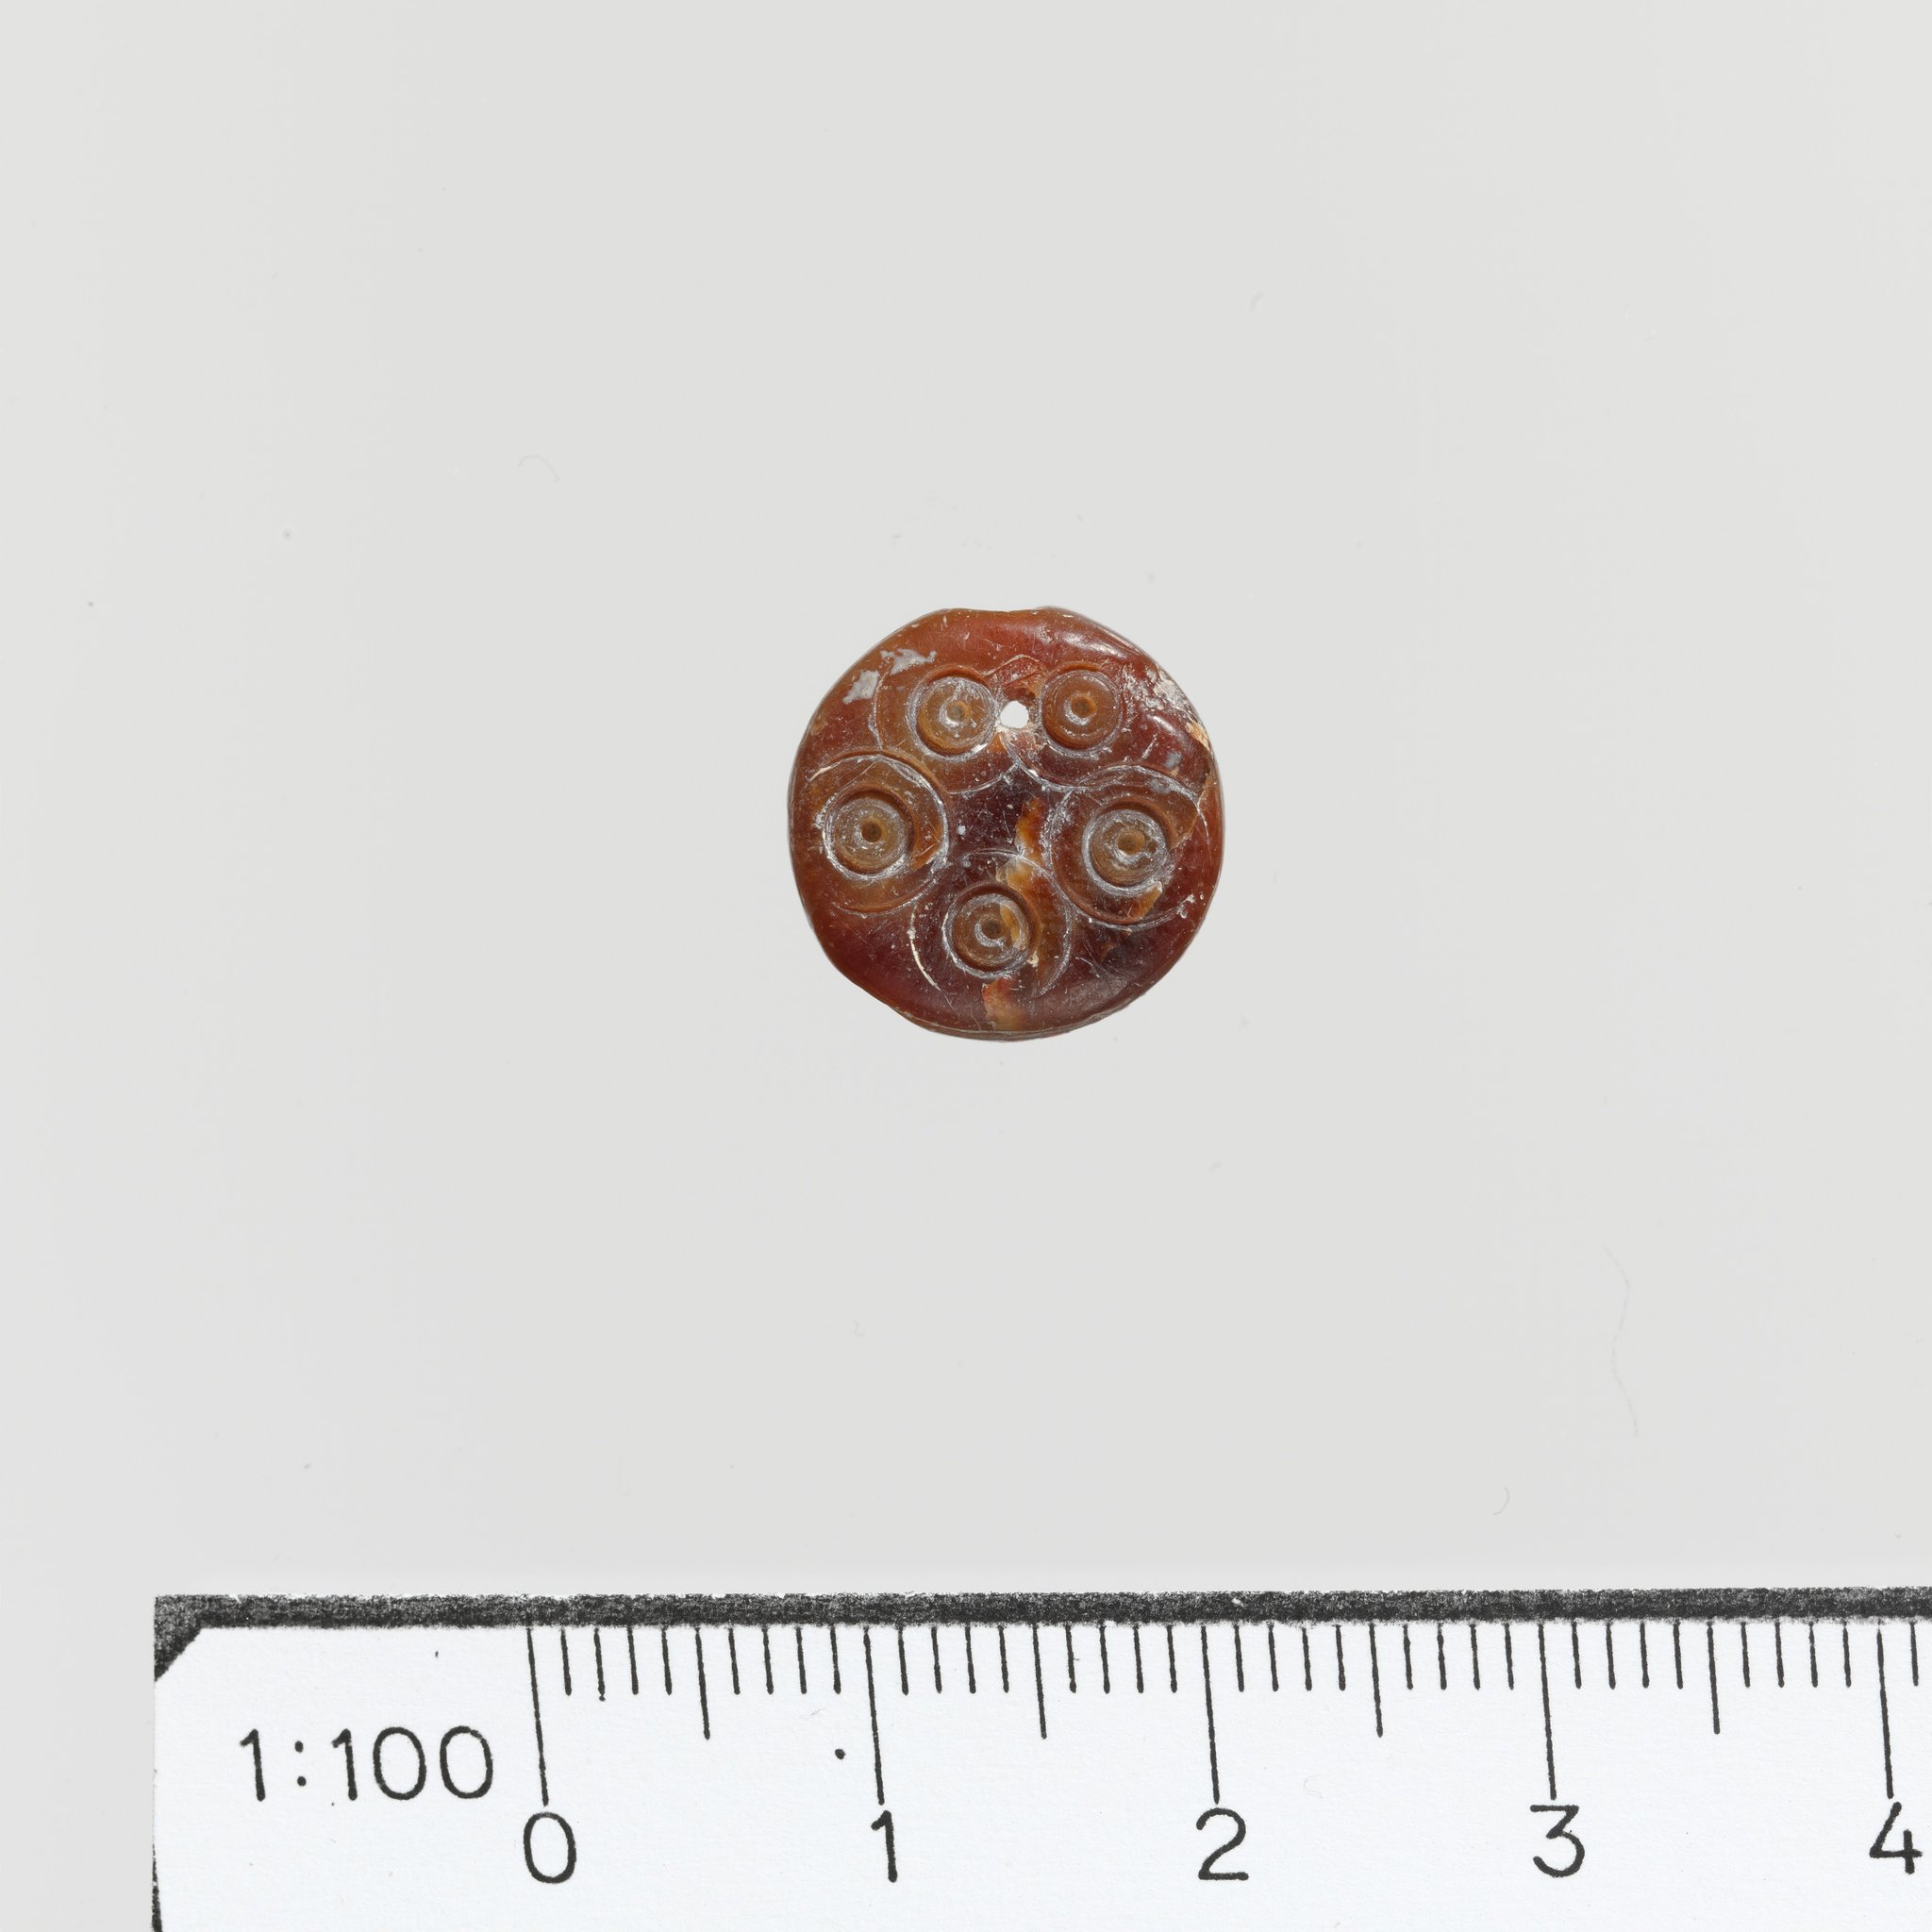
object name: seal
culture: minoan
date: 2600-2000 BCE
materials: stone